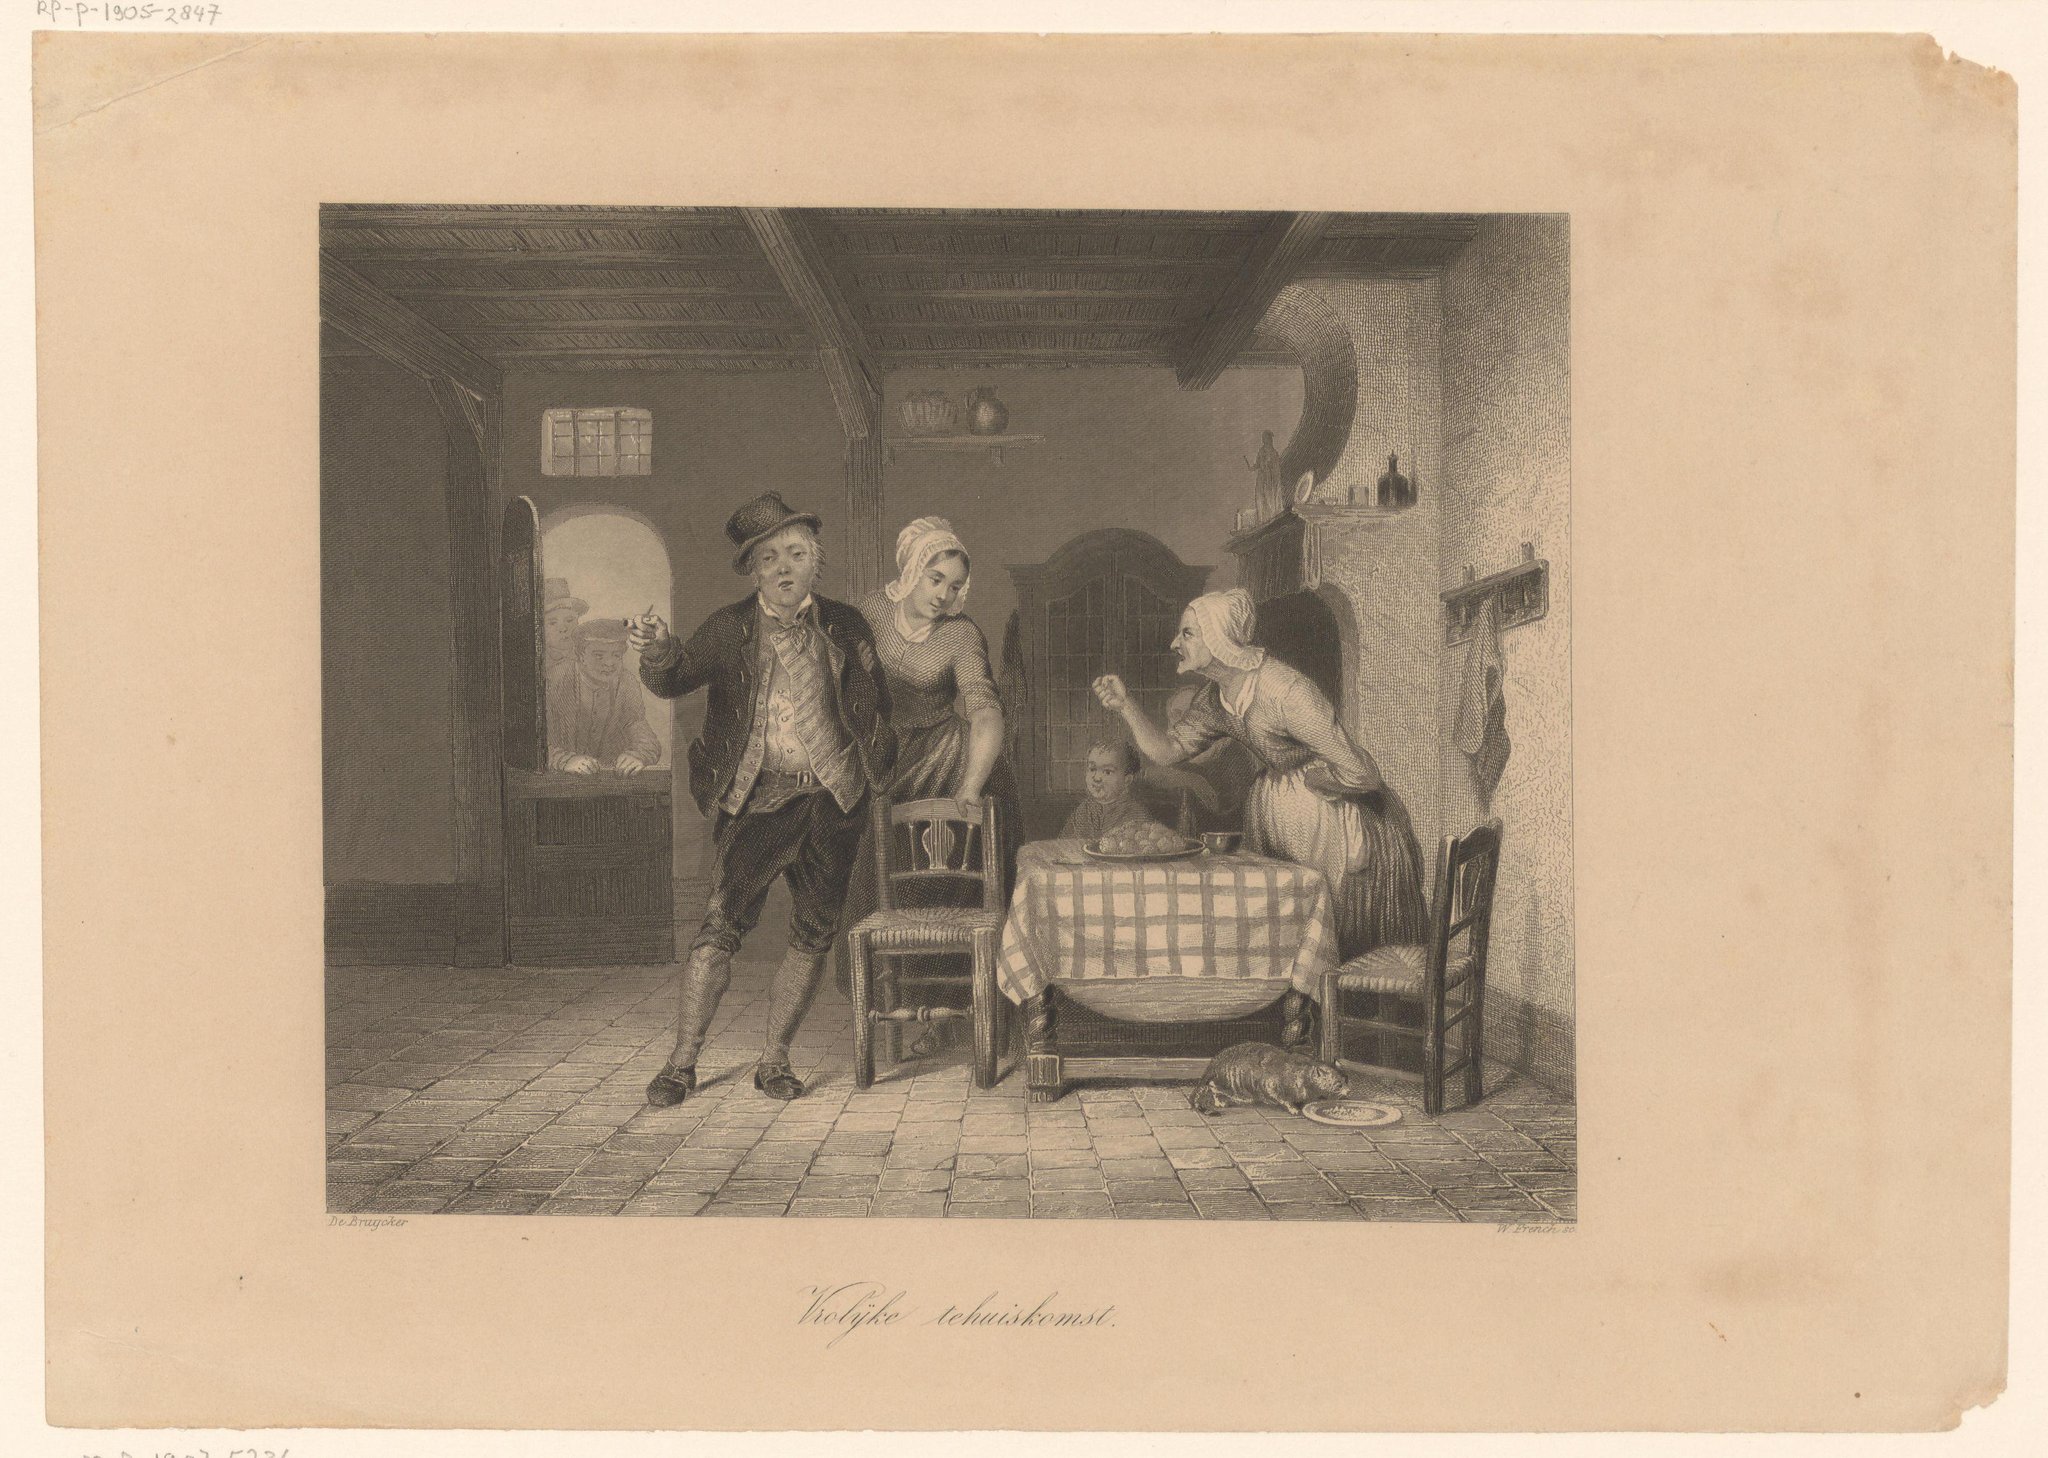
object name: print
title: Man en twee vrouwen in een woonkamer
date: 1826-1898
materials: paper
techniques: engraving, etching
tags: satire on marriage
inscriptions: collector's mark: Lugt 2228